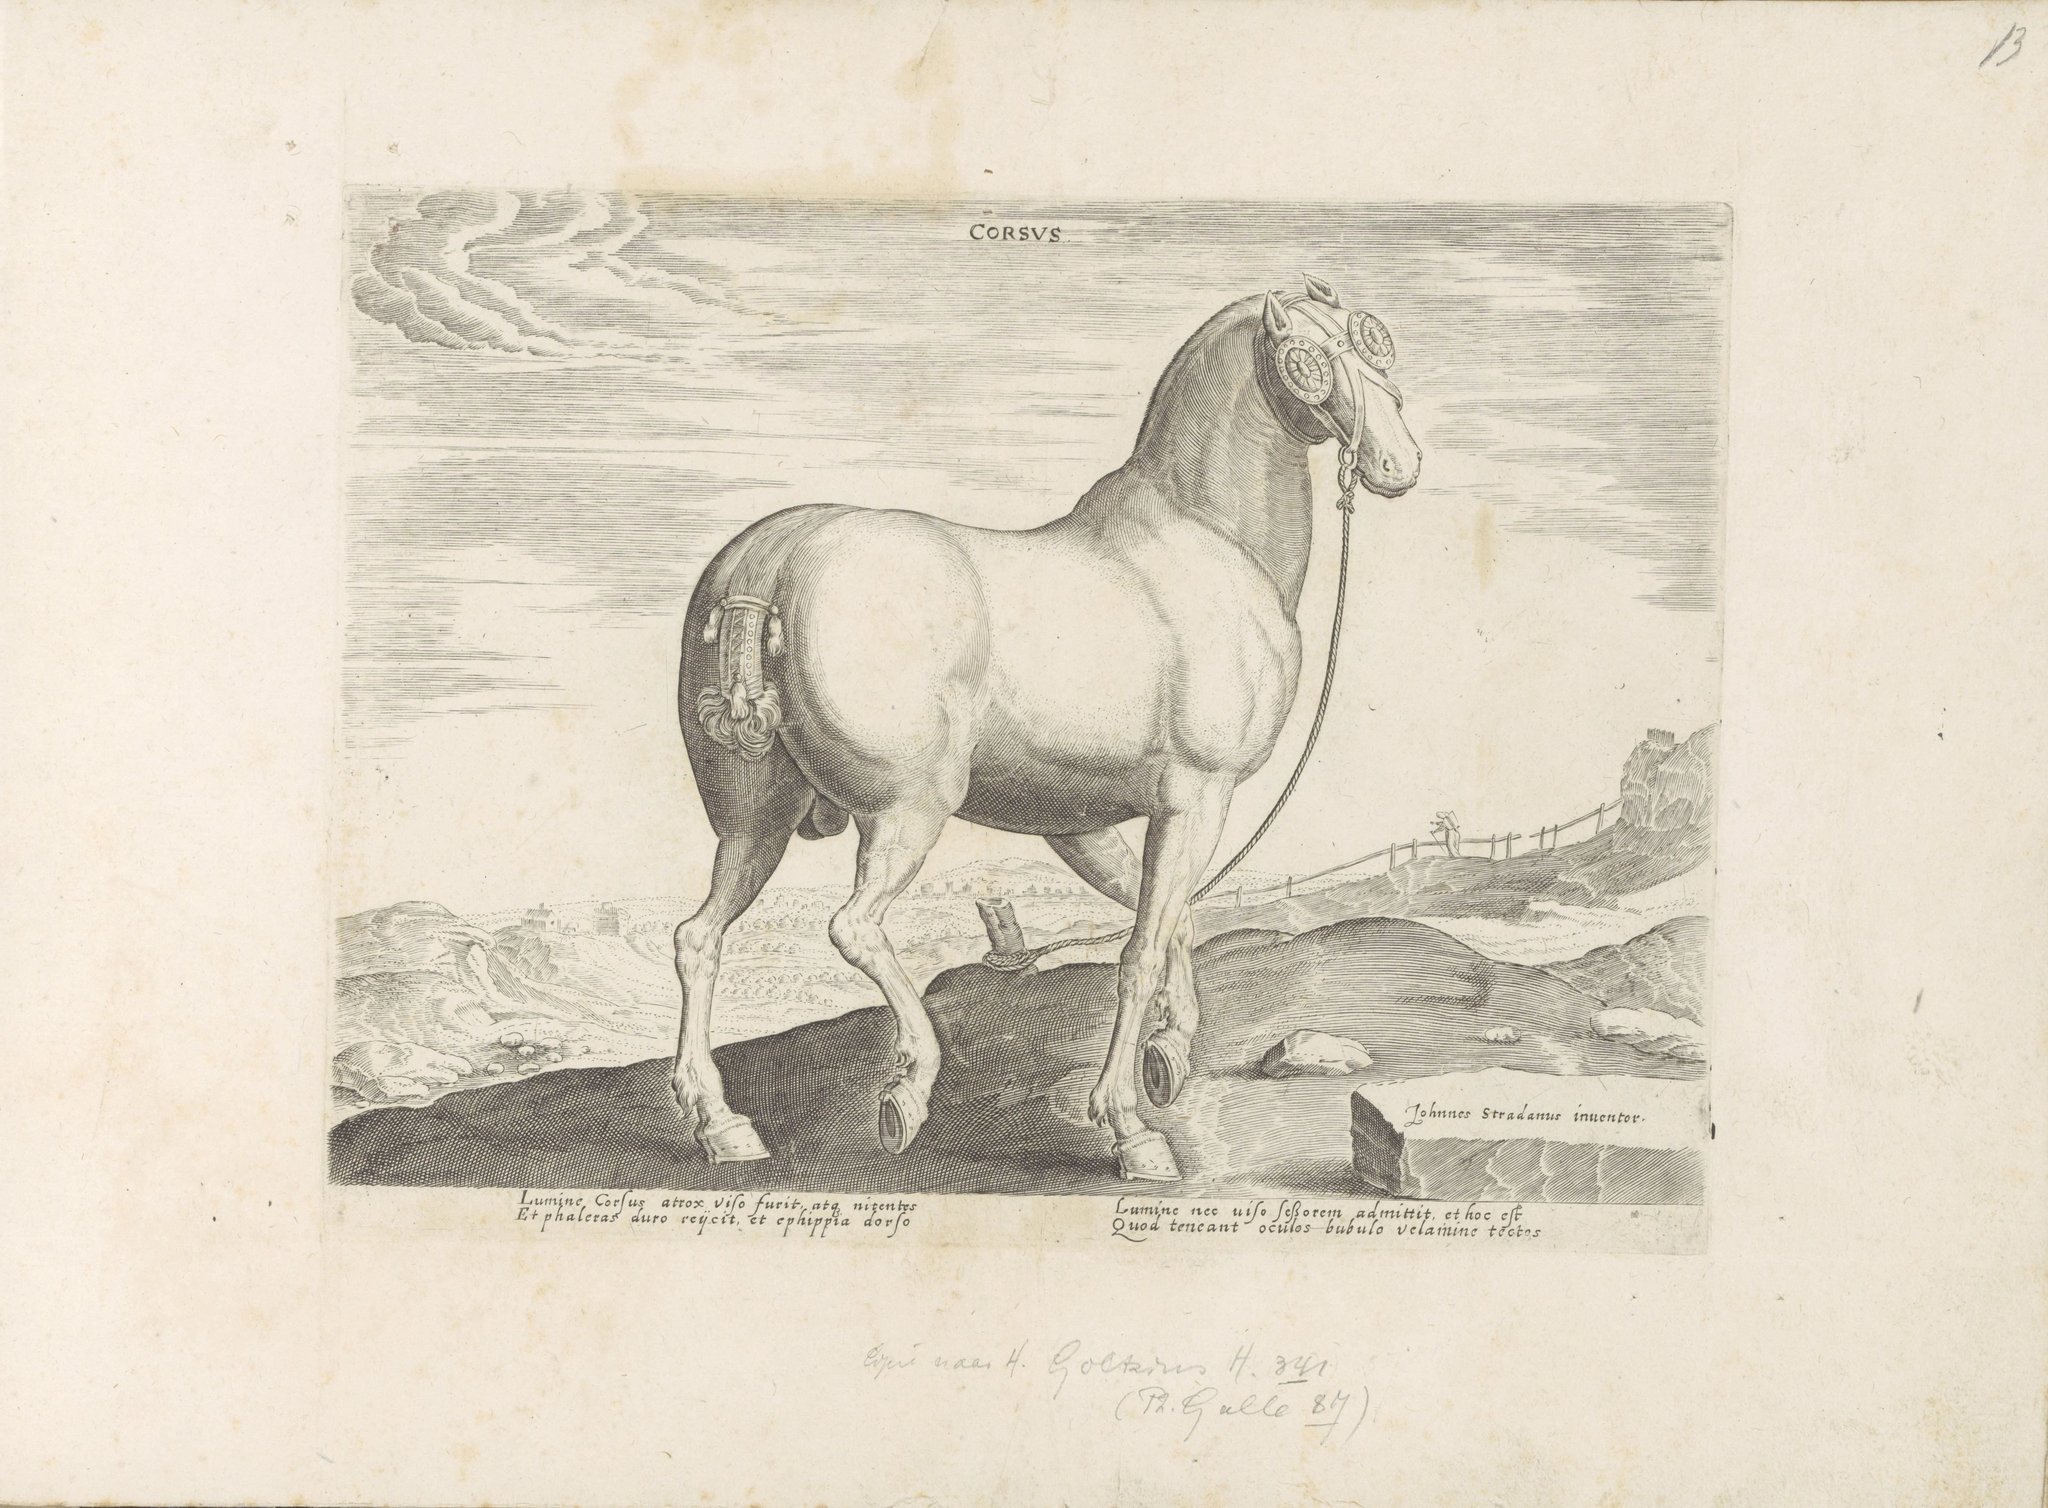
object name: album leaf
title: Paard uit Corsica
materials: paper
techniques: engraving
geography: venice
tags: don juan van oostenrijk, horses and kindred animals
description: Een Corsicaans paard, schuin van achteren gezien. Prent maakt deel uit van een album.